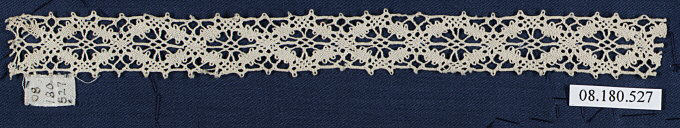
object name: insertion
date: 1501-1600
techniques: lace